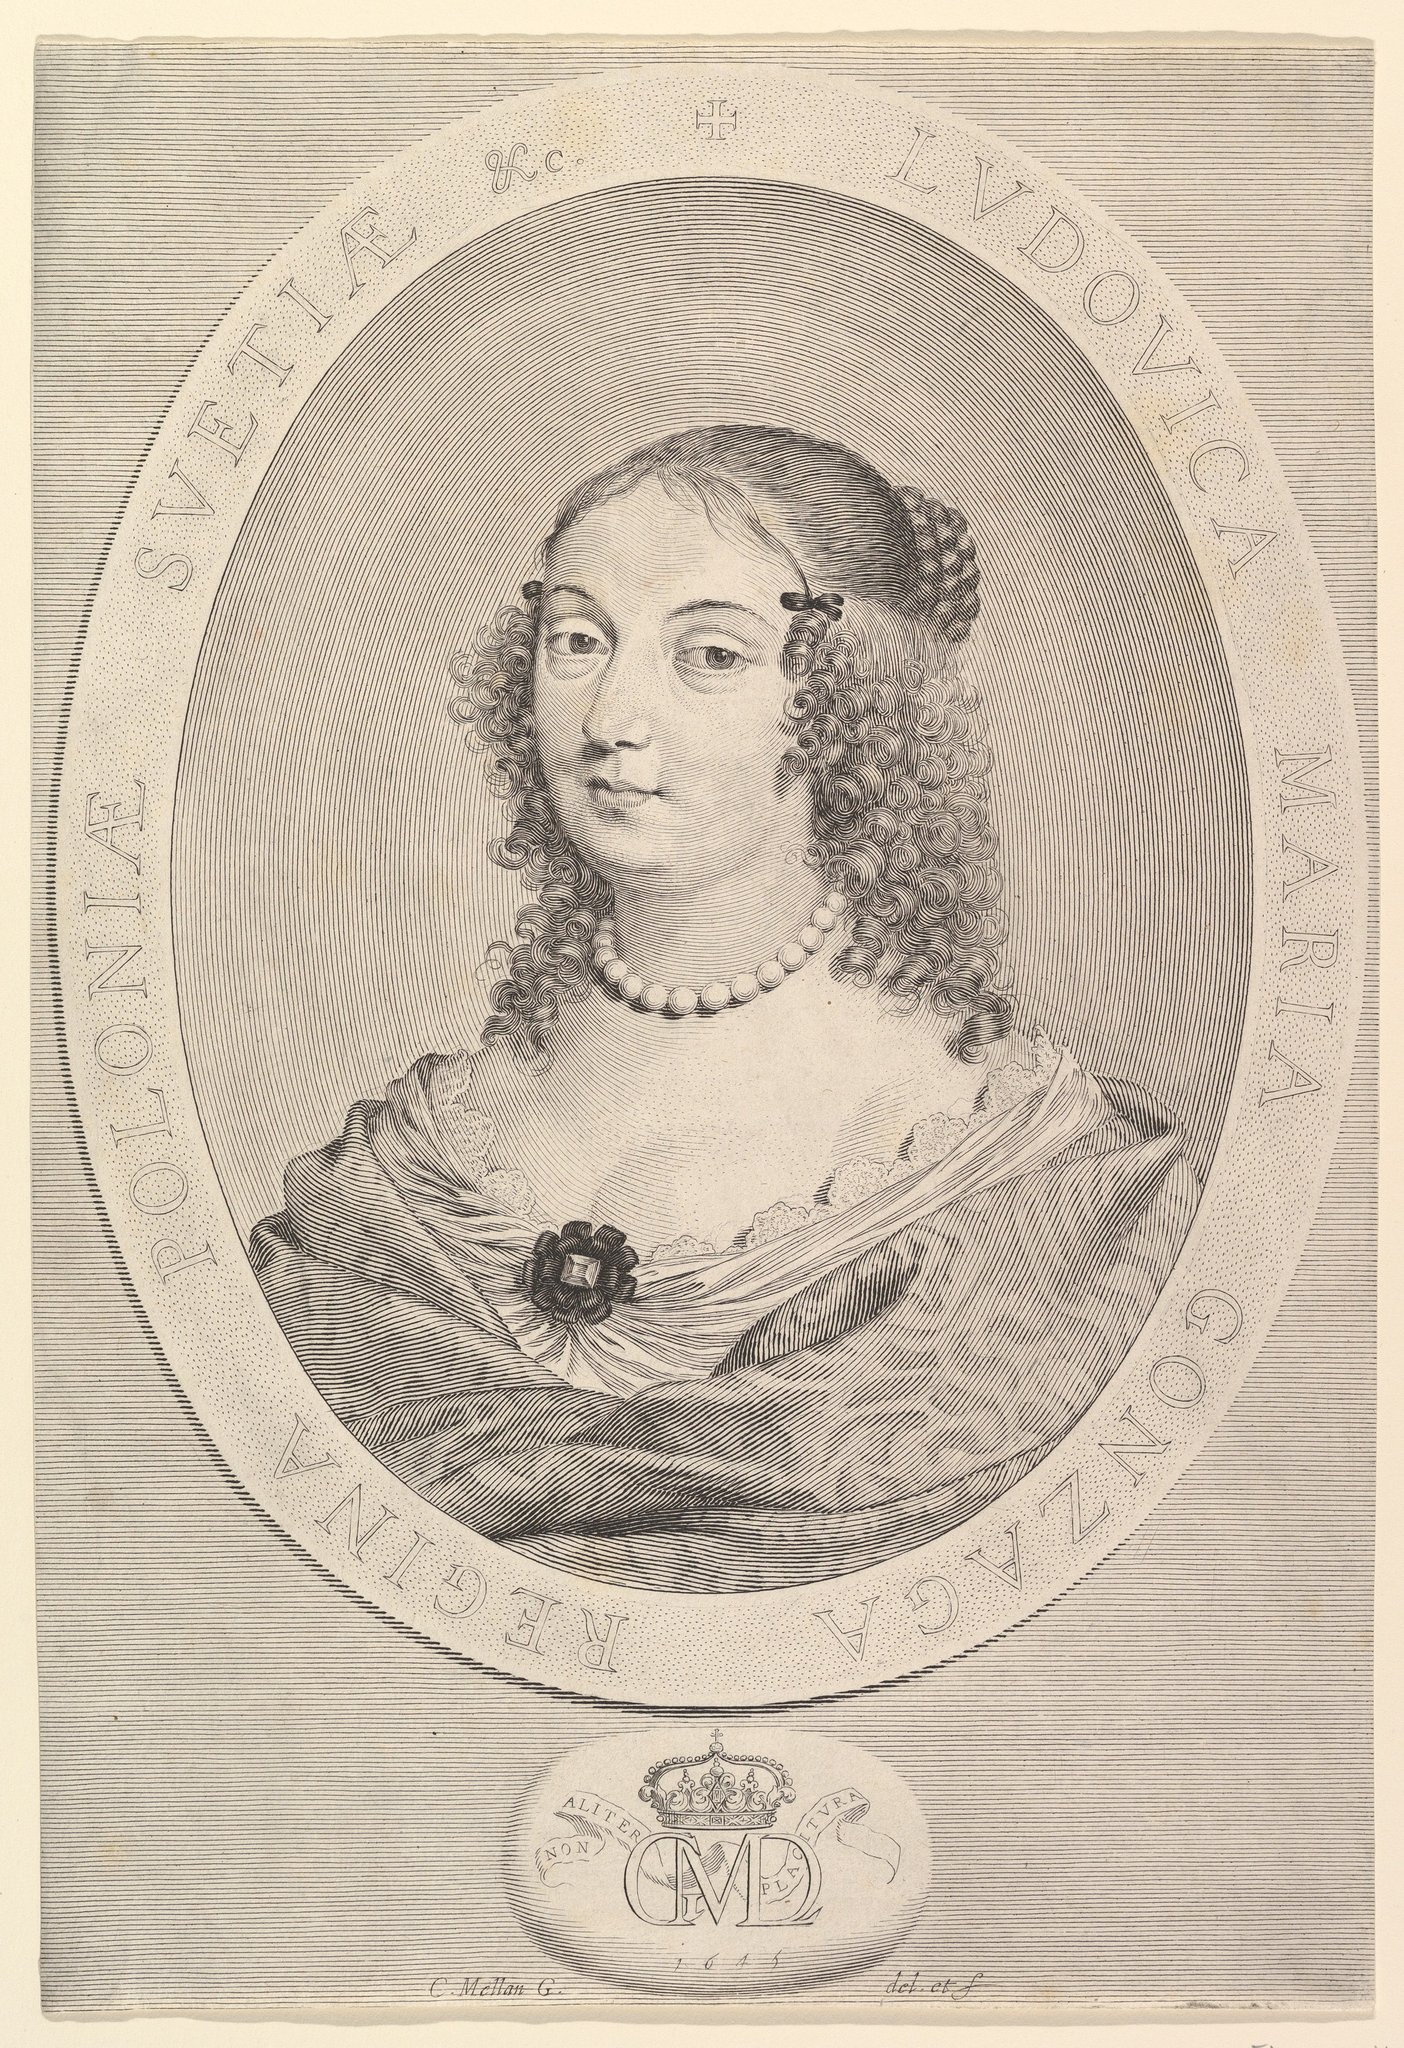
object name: print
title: Ludovica Maria Gonzaga, Queen of Poland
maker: claude mellan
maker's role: artist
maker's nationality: french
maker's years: 1598-1688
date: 1645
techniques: engraving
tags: queens,portraits